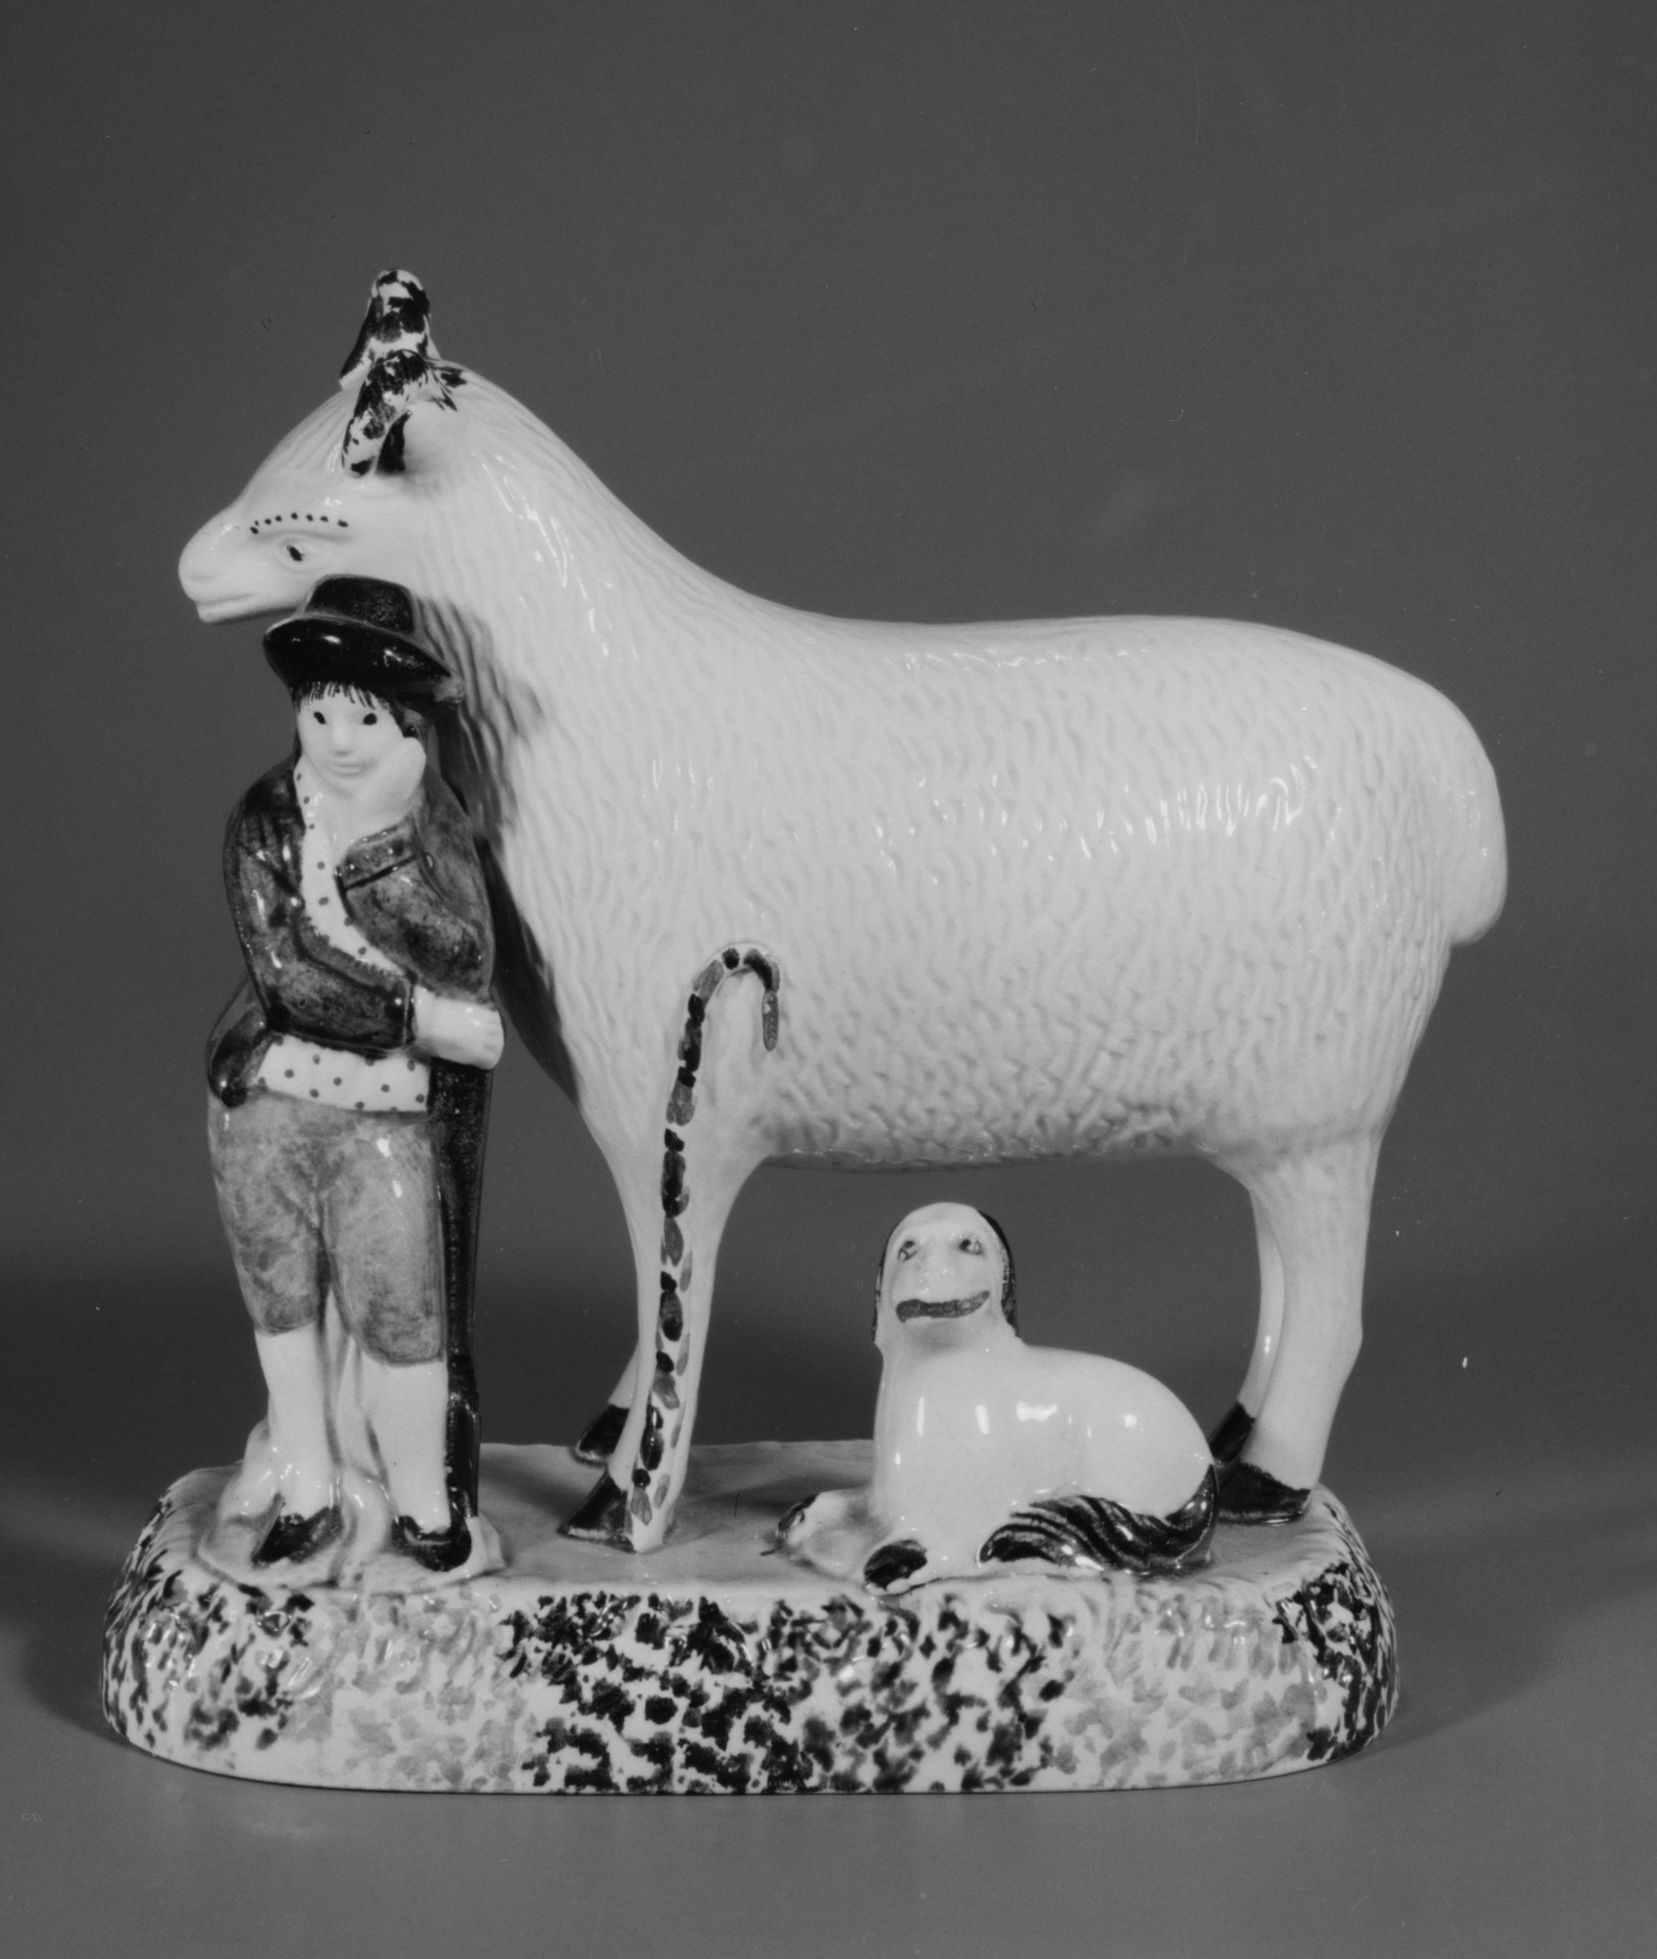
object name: figure group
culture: british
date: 1785-1835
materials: earthenware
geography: england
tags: animals,boys